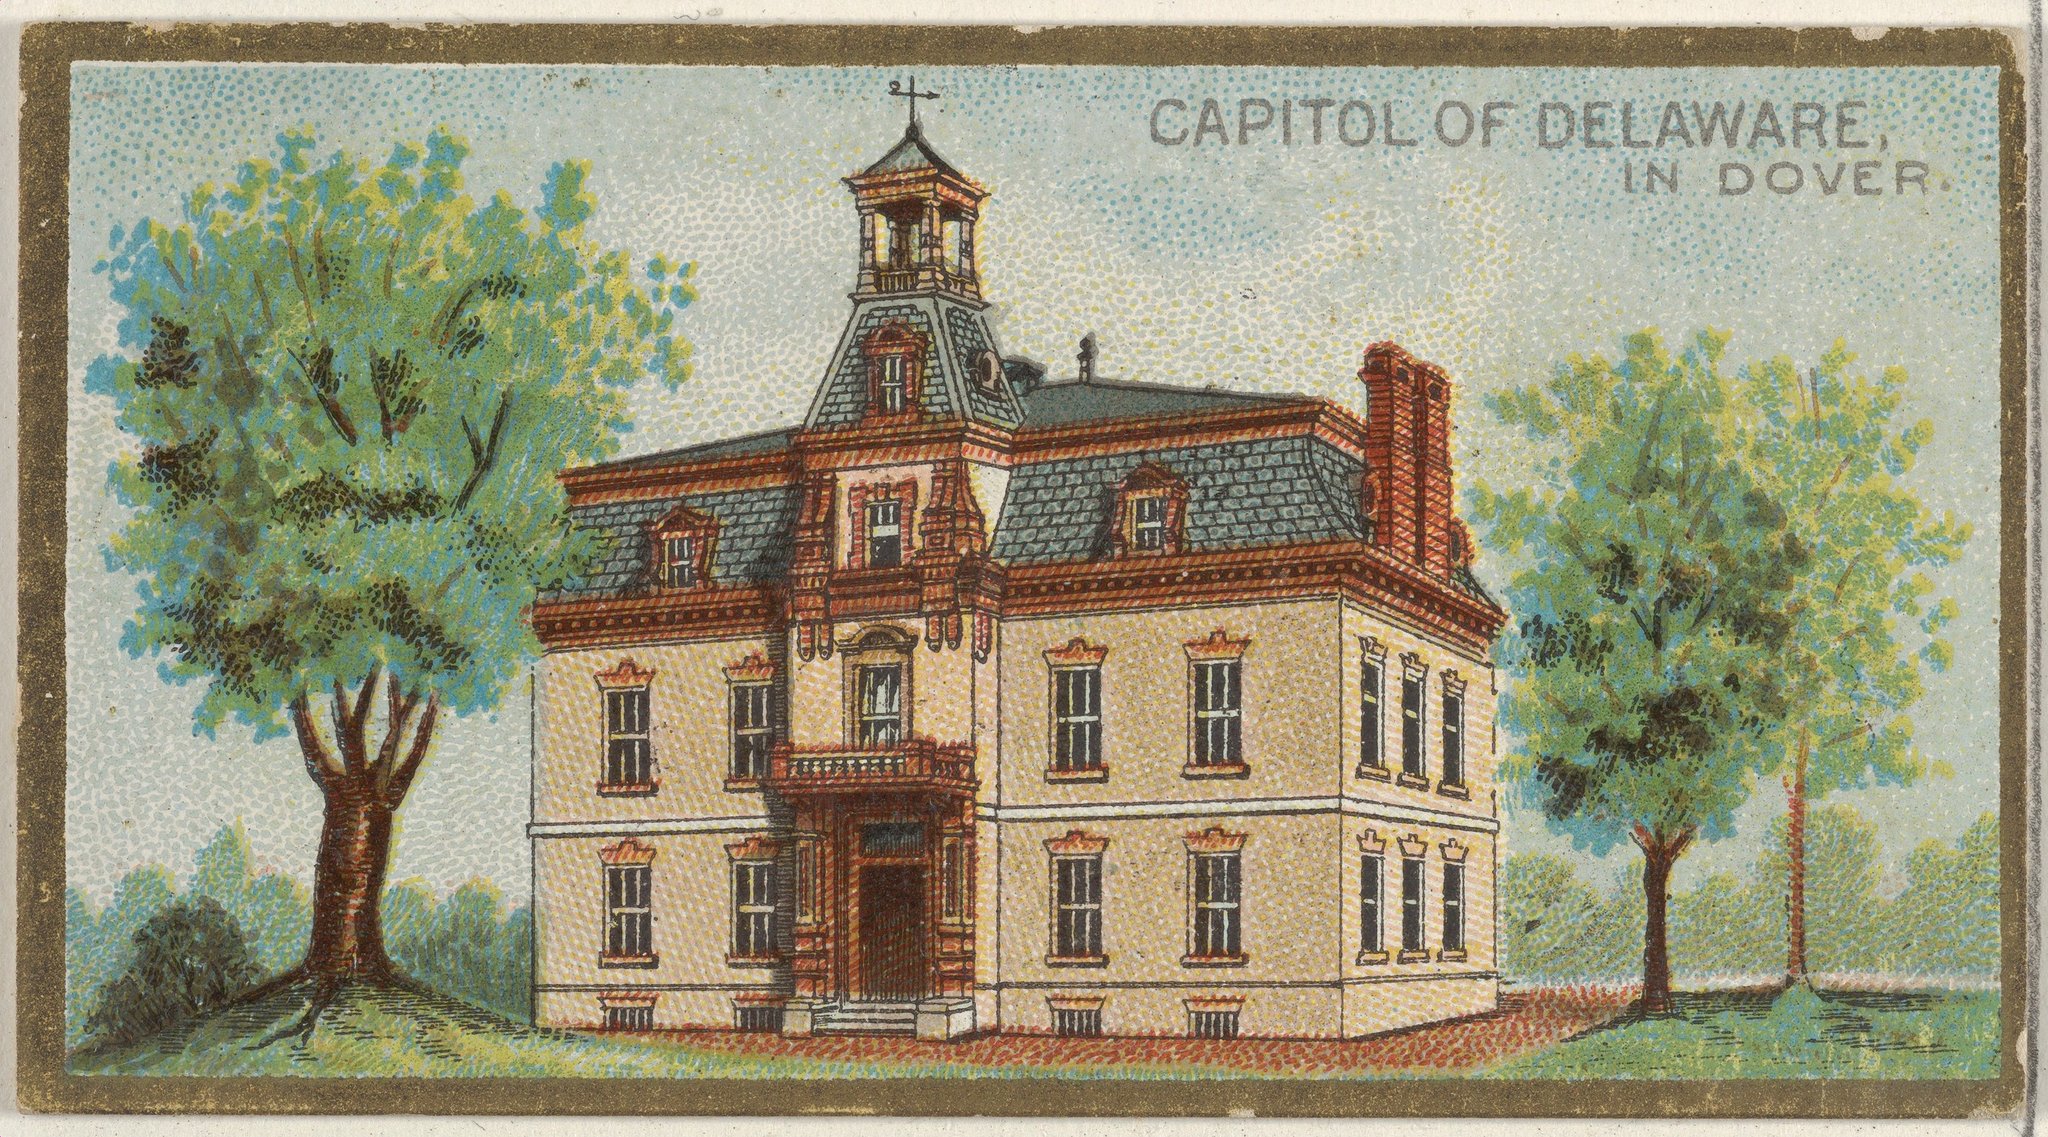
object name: print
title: Capitol of Delaware in Dover, from the General Government and State Capitol Buildings series (N14) for Allen & Ginter Cigarettes Brands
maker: allen & ginter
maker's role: publisher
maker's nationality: american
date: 1889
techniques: color lithograph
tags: buildings